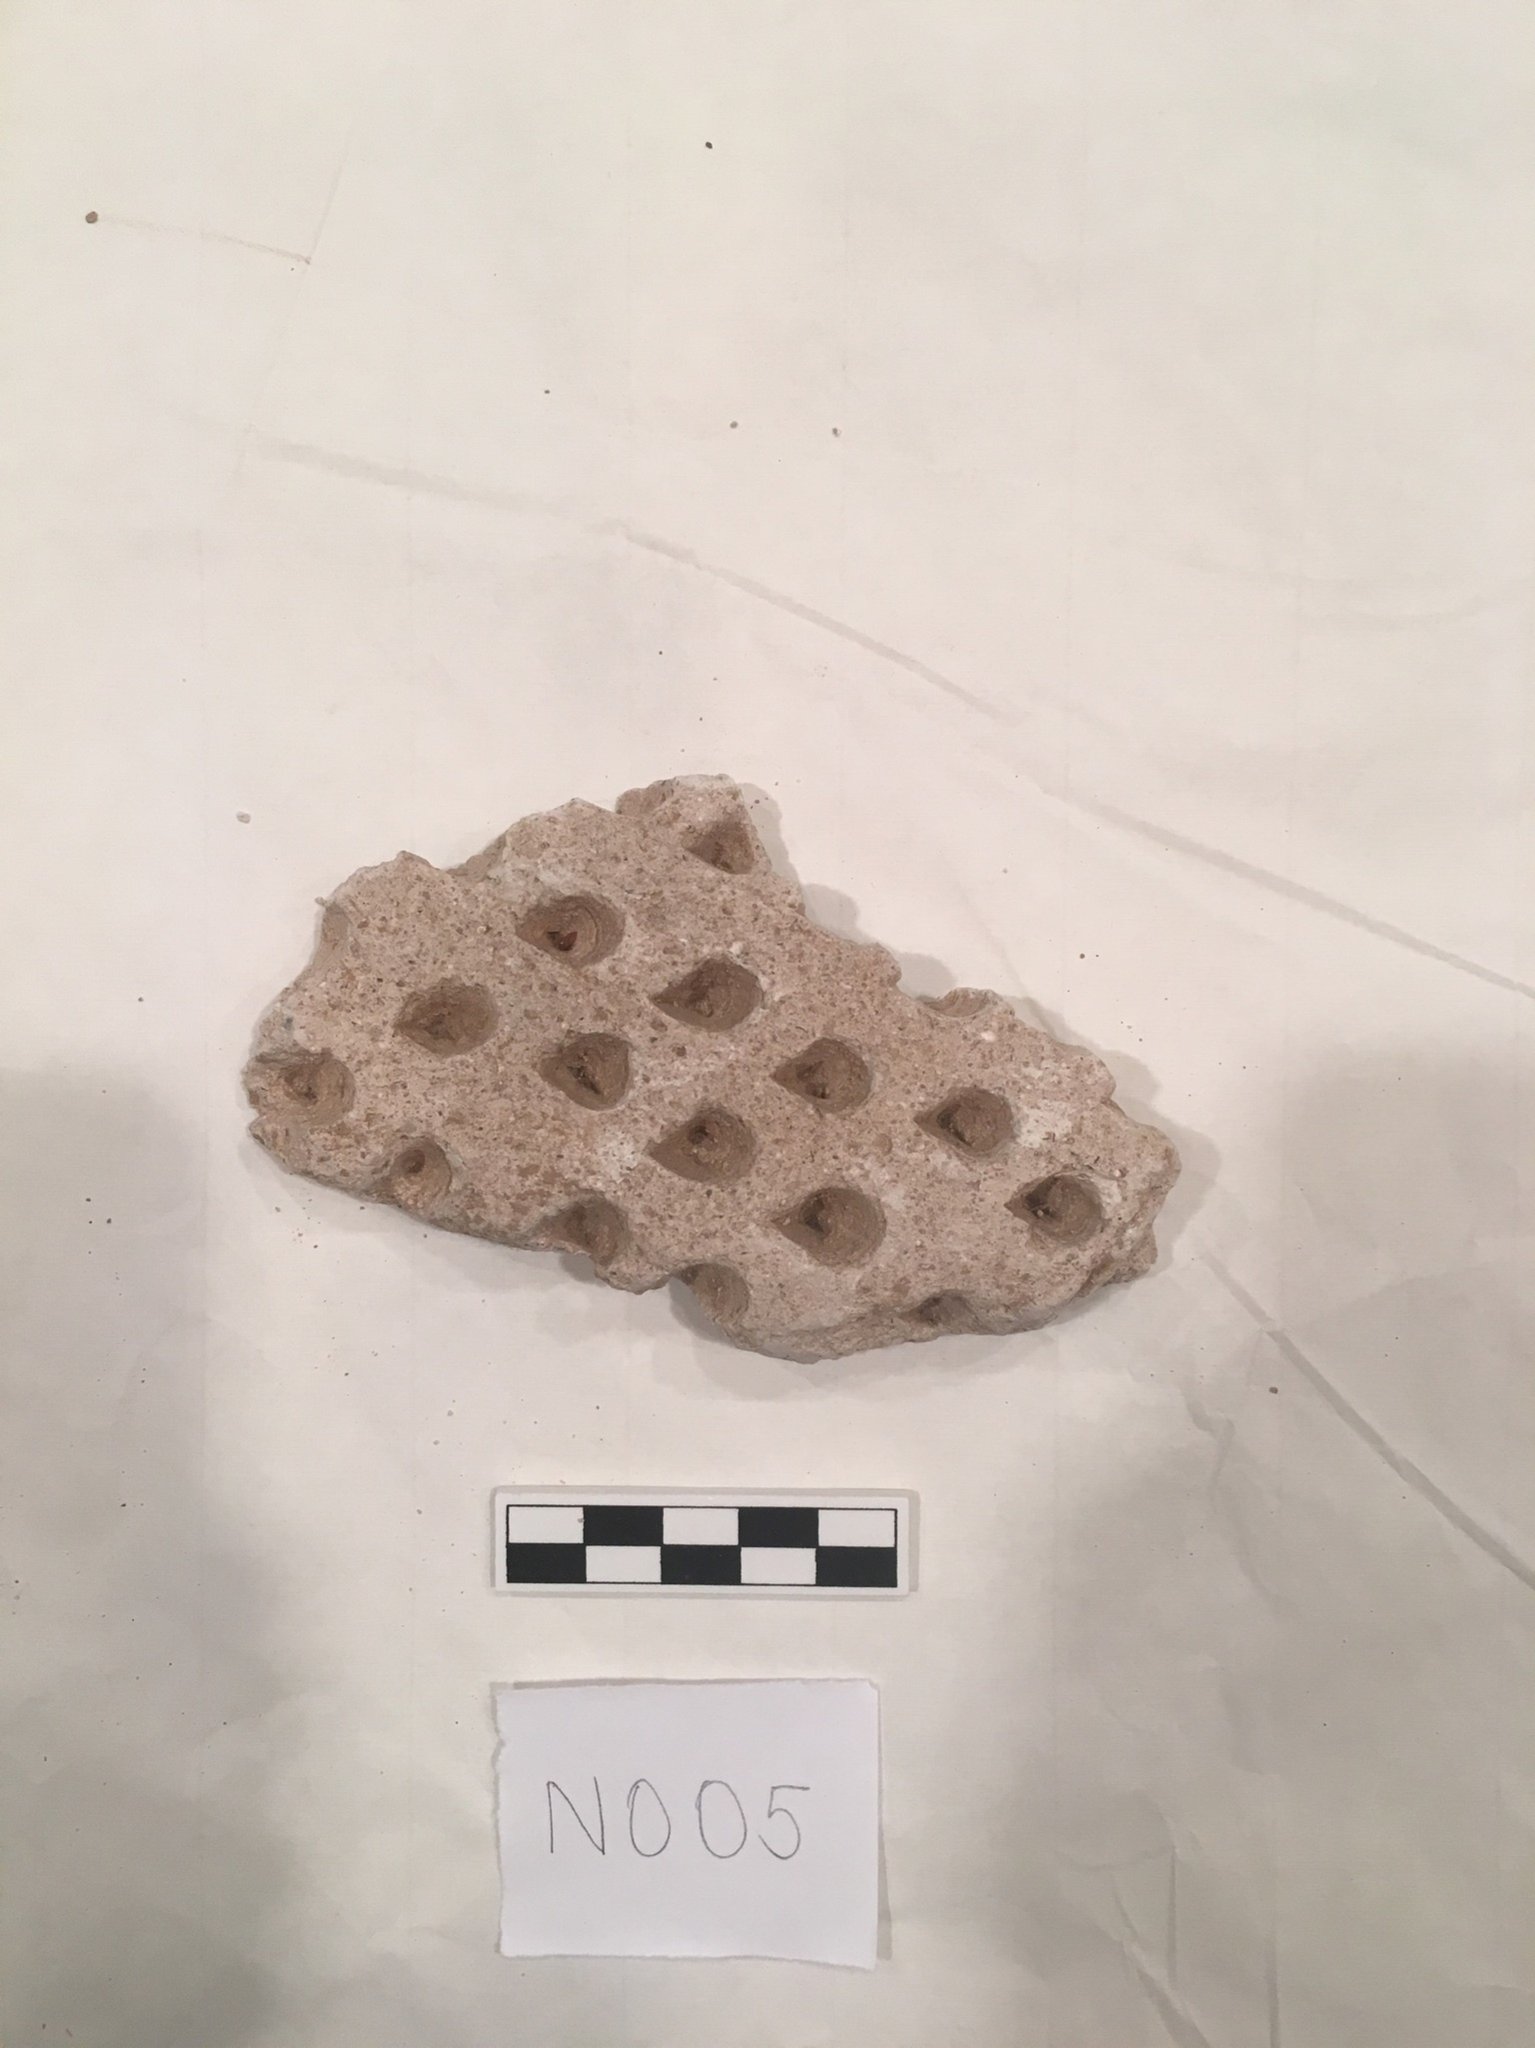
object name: fragment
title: Stucco Fragment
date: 701-1200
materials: plaster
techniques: carving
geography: iran